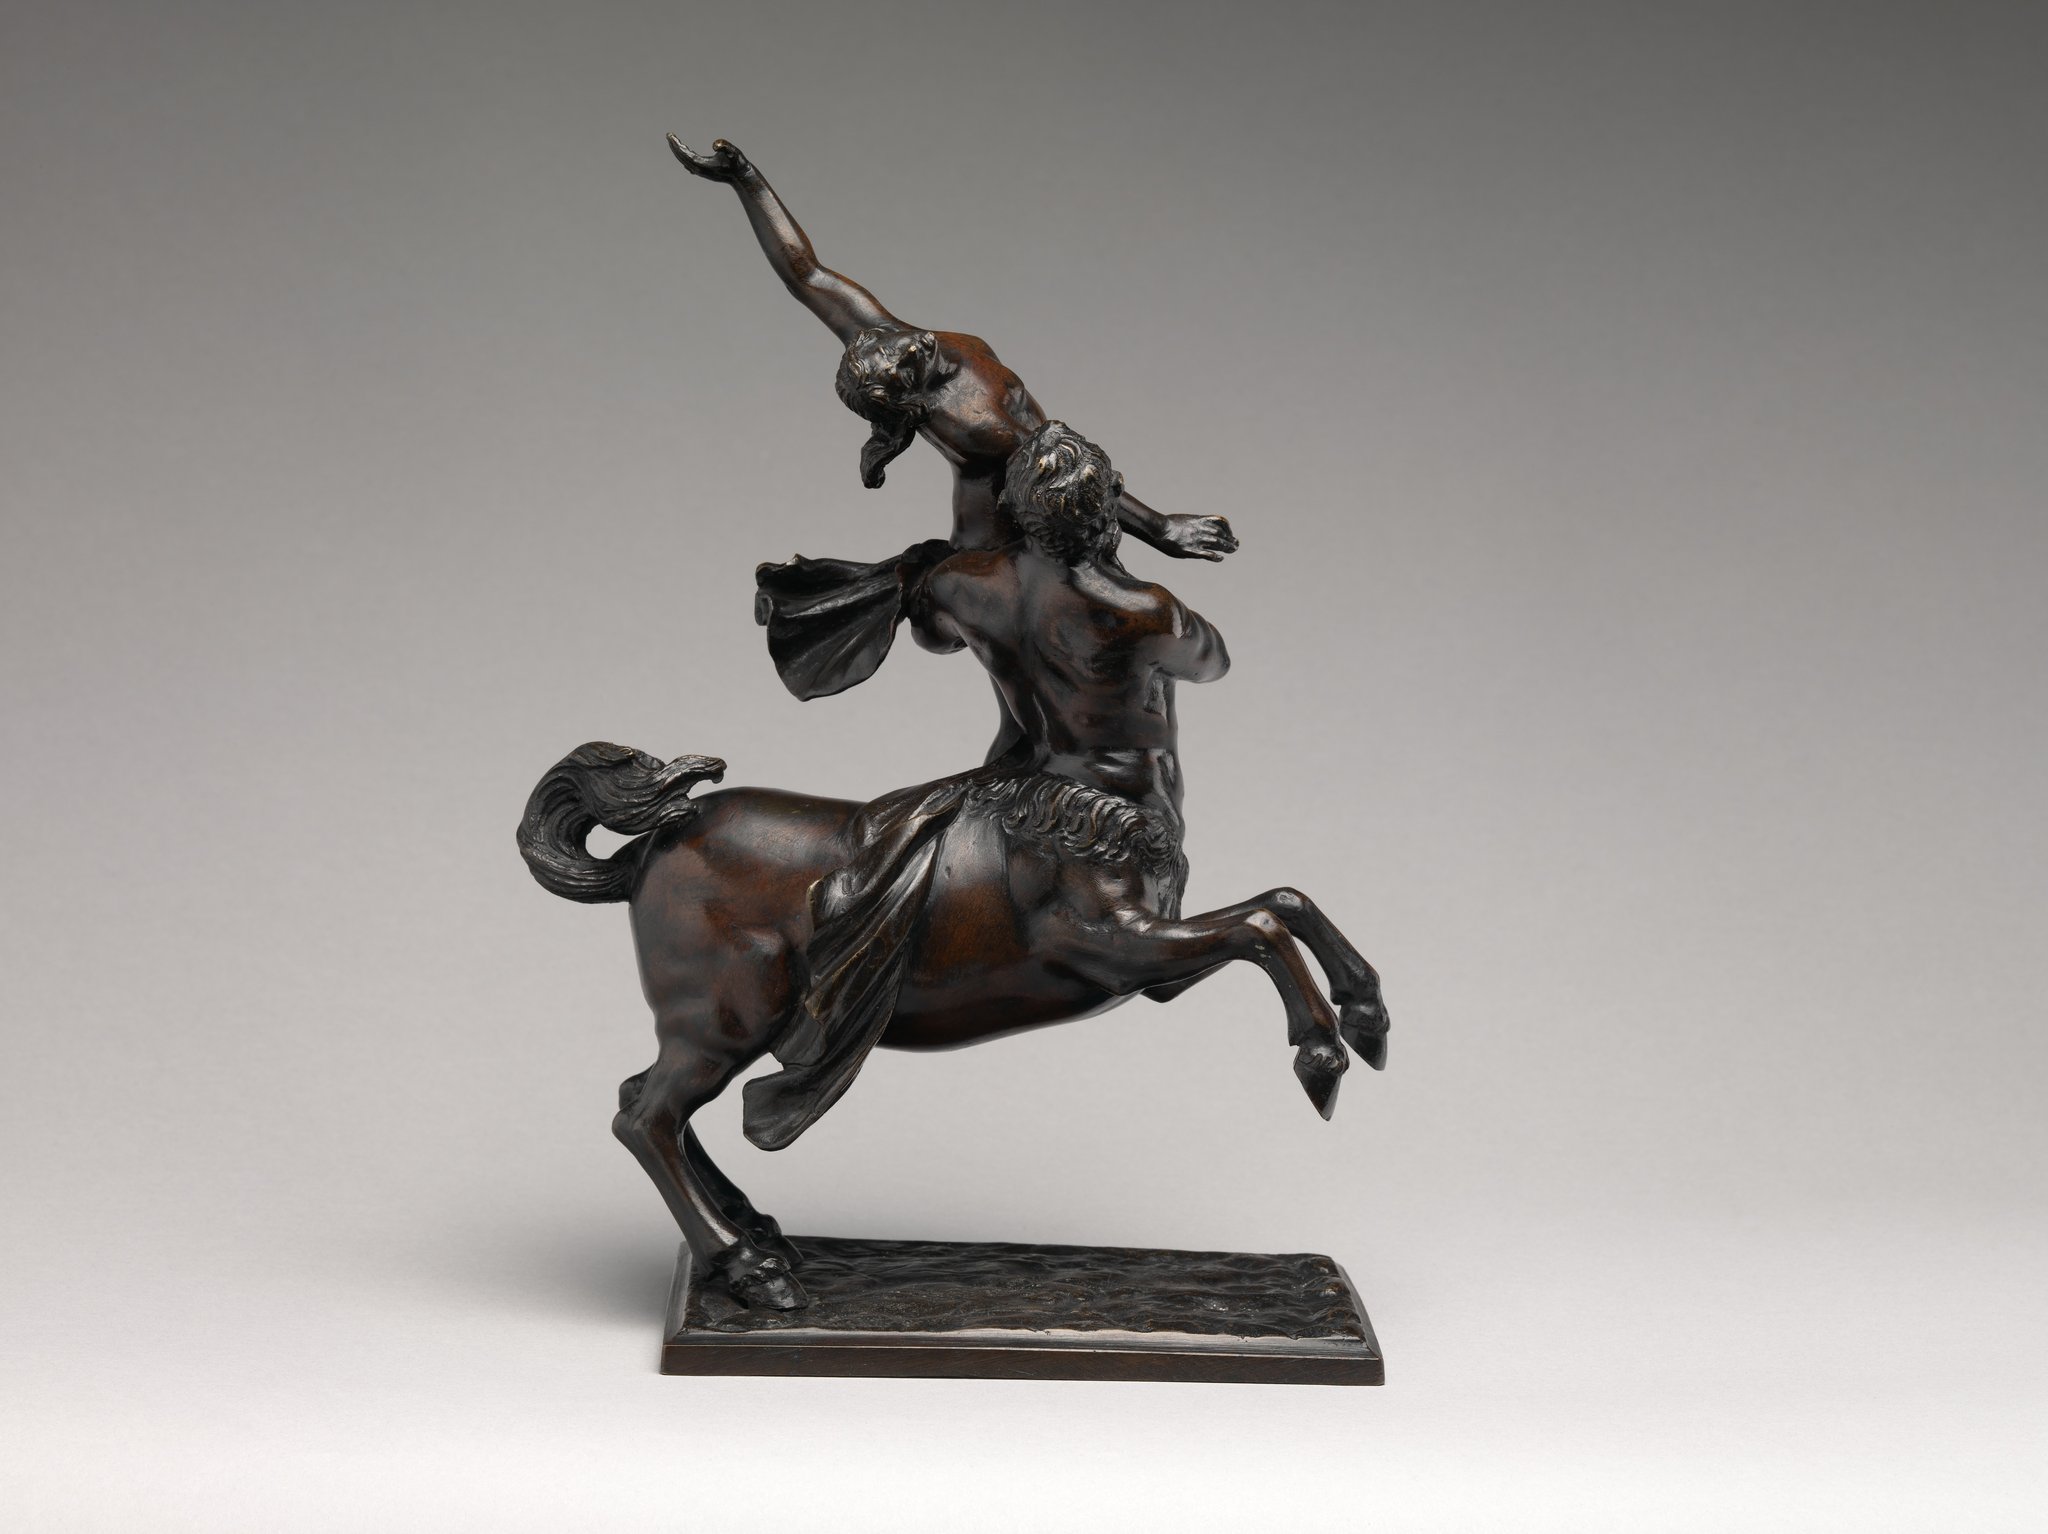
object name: statuette group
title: Nessus and Dejanira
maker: francesco fanelli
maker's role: artist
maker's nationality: italian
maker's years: 1608-1665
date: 1667-1700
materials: bronze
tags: female nudes,centaurs